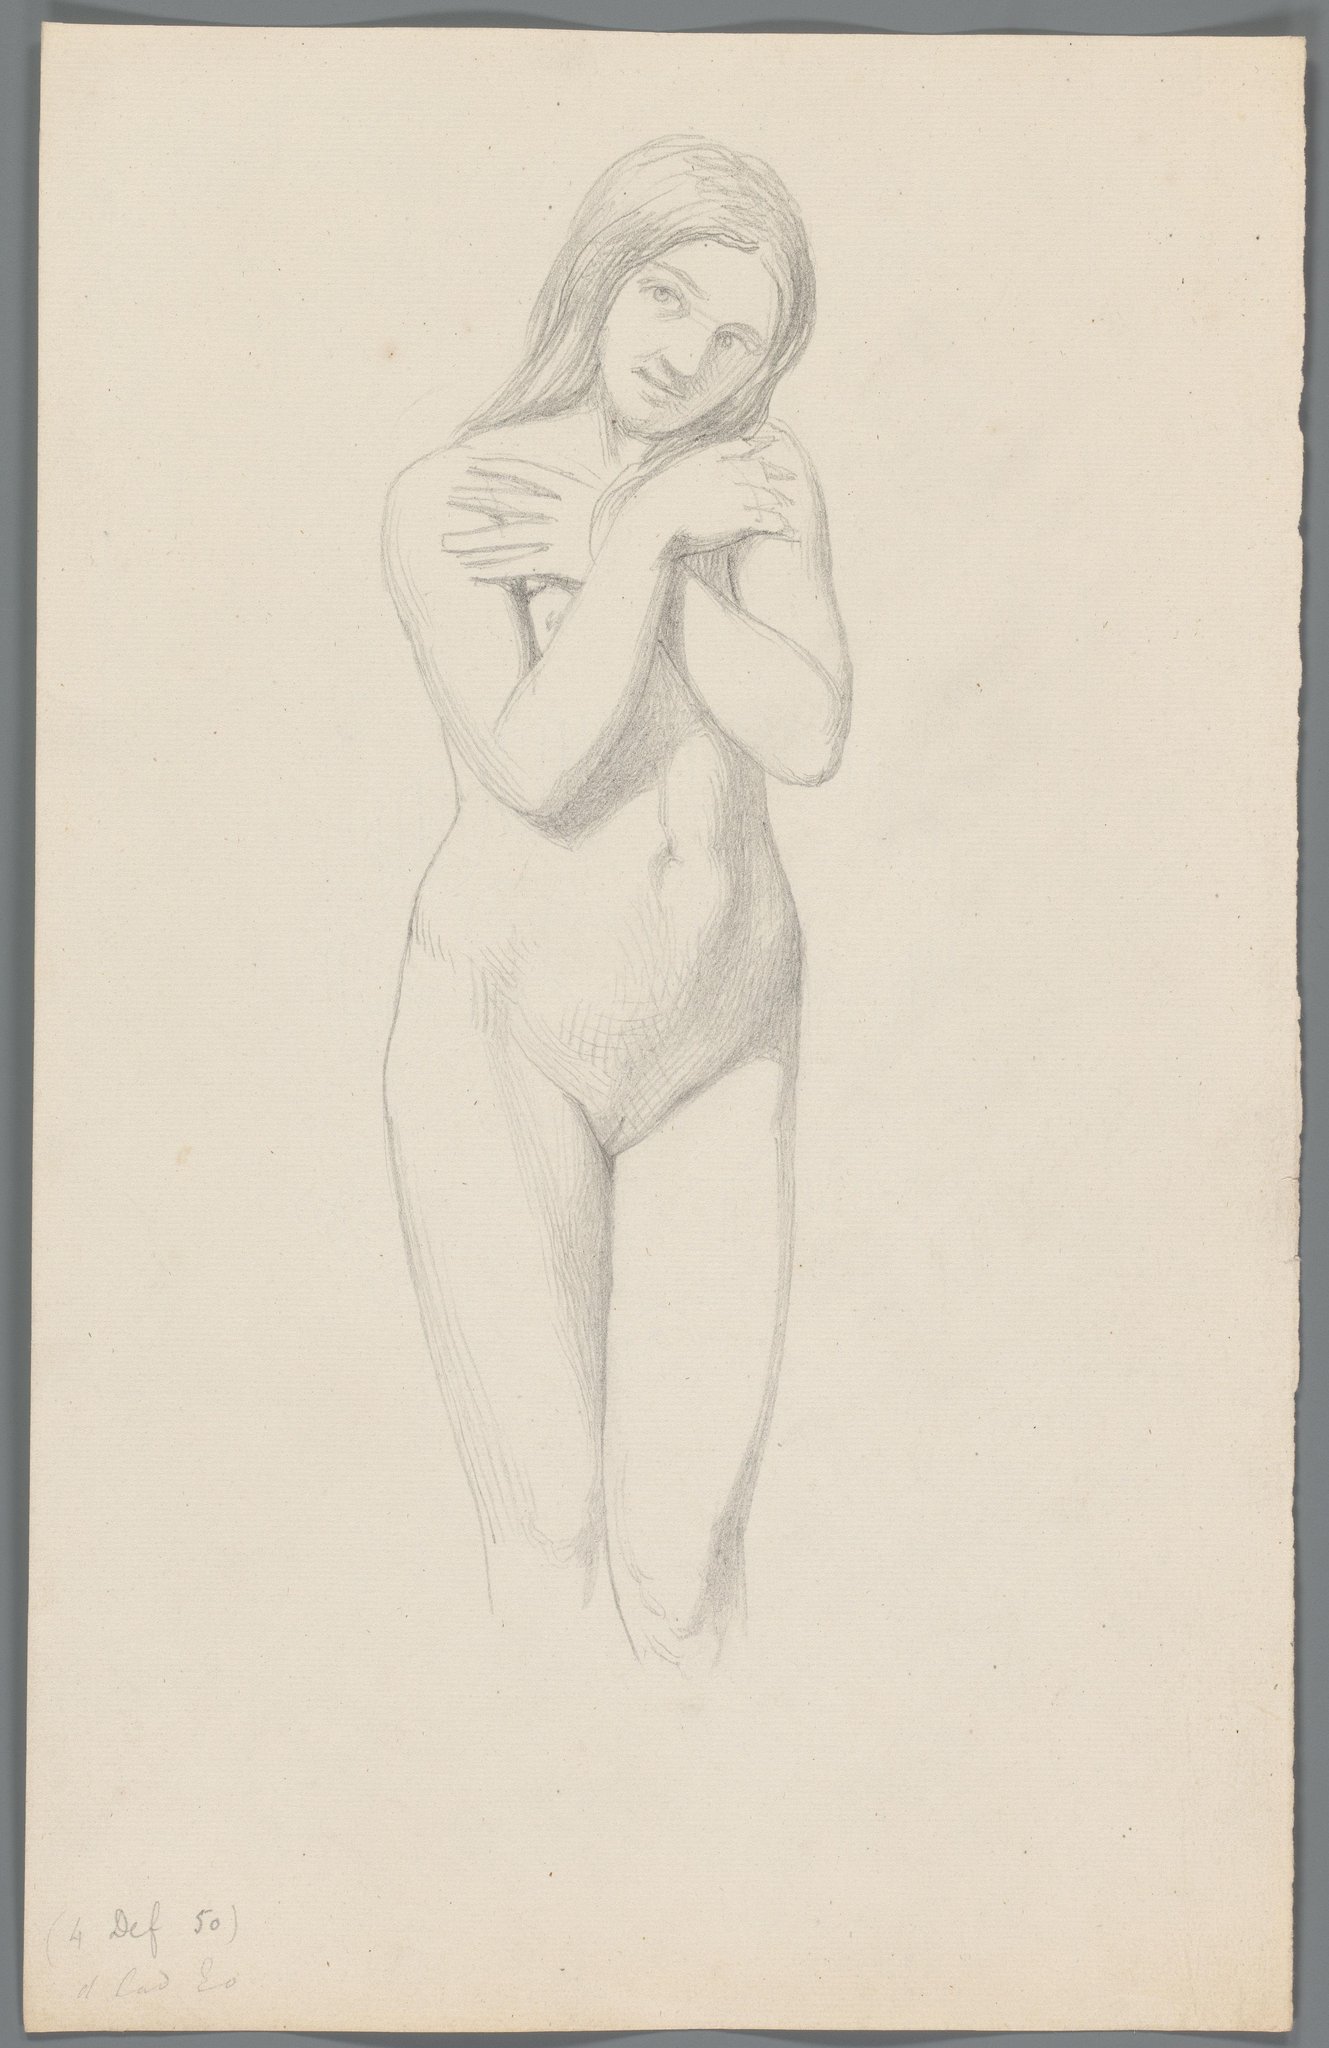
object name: drawing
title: Naakte jonge vrouw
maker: jacobus everhardus josephus van den berg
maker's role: draughtsman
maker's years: 1802-1861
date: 1850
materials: paper, pencil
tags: the (nude) human figure; 'corpo humano' (ripa) - aa - female human figure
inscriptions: inscription: ‘(4 Def 50) (...)’